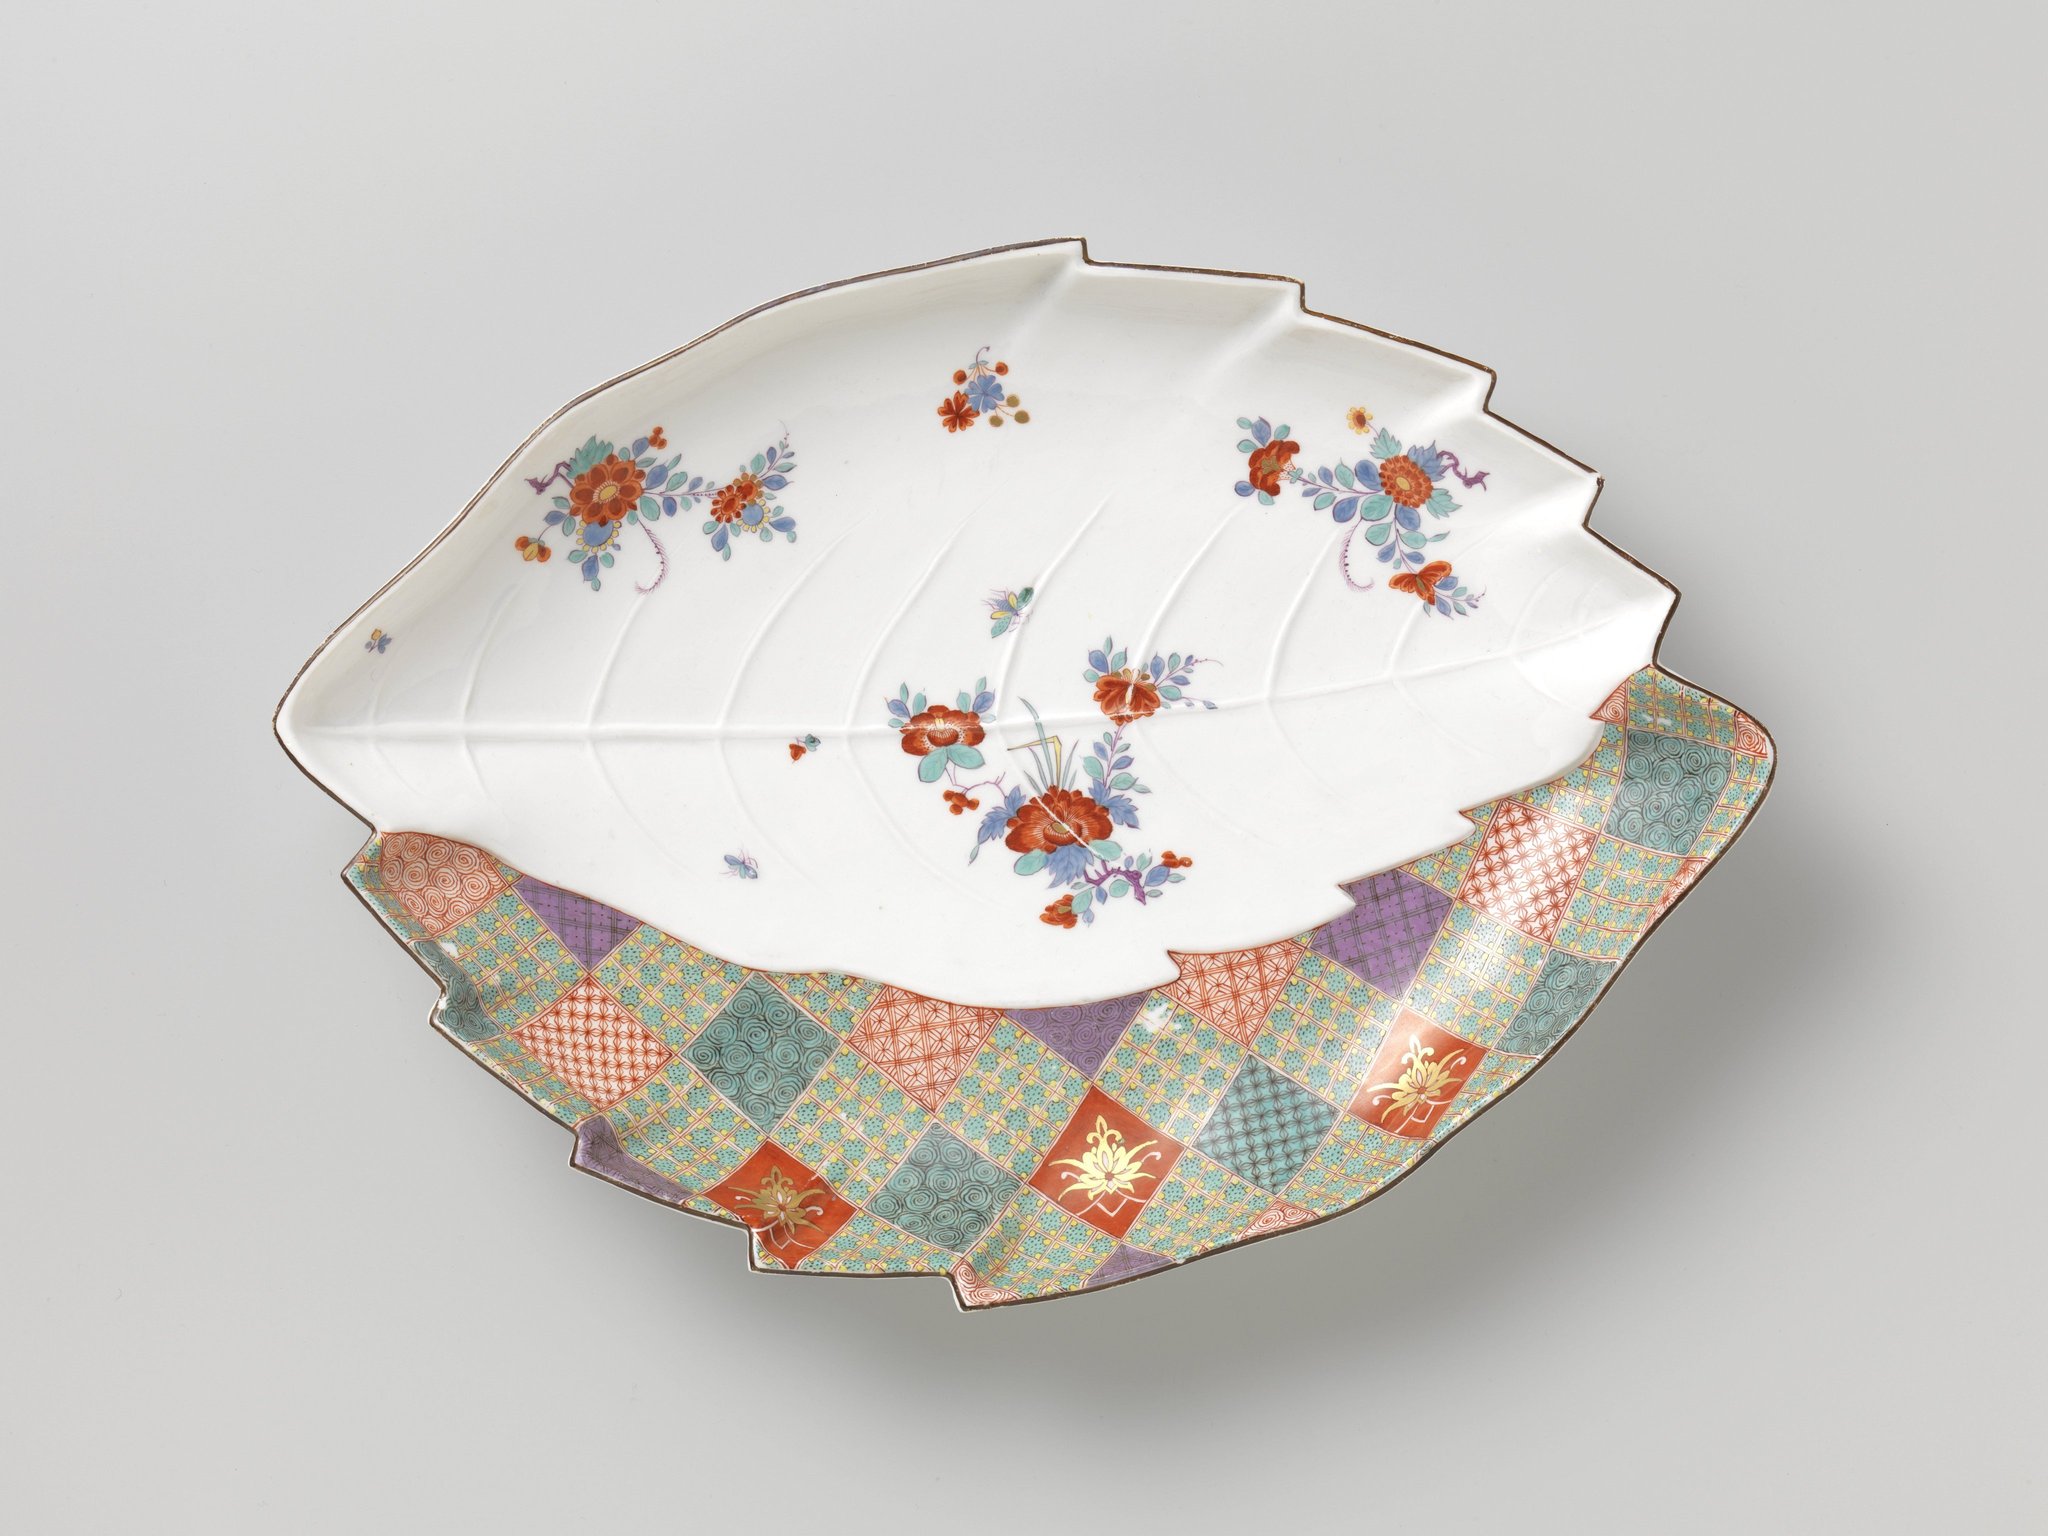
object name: platter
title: Schotel, veelkleurig beschilderd met een Kakiemon- en een Imari-decor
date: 1730-1735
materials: porcelain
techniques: painted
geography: meissen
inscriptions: mold mark, factory mark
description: Dish. Porcelain, Meissen, c. 1730.